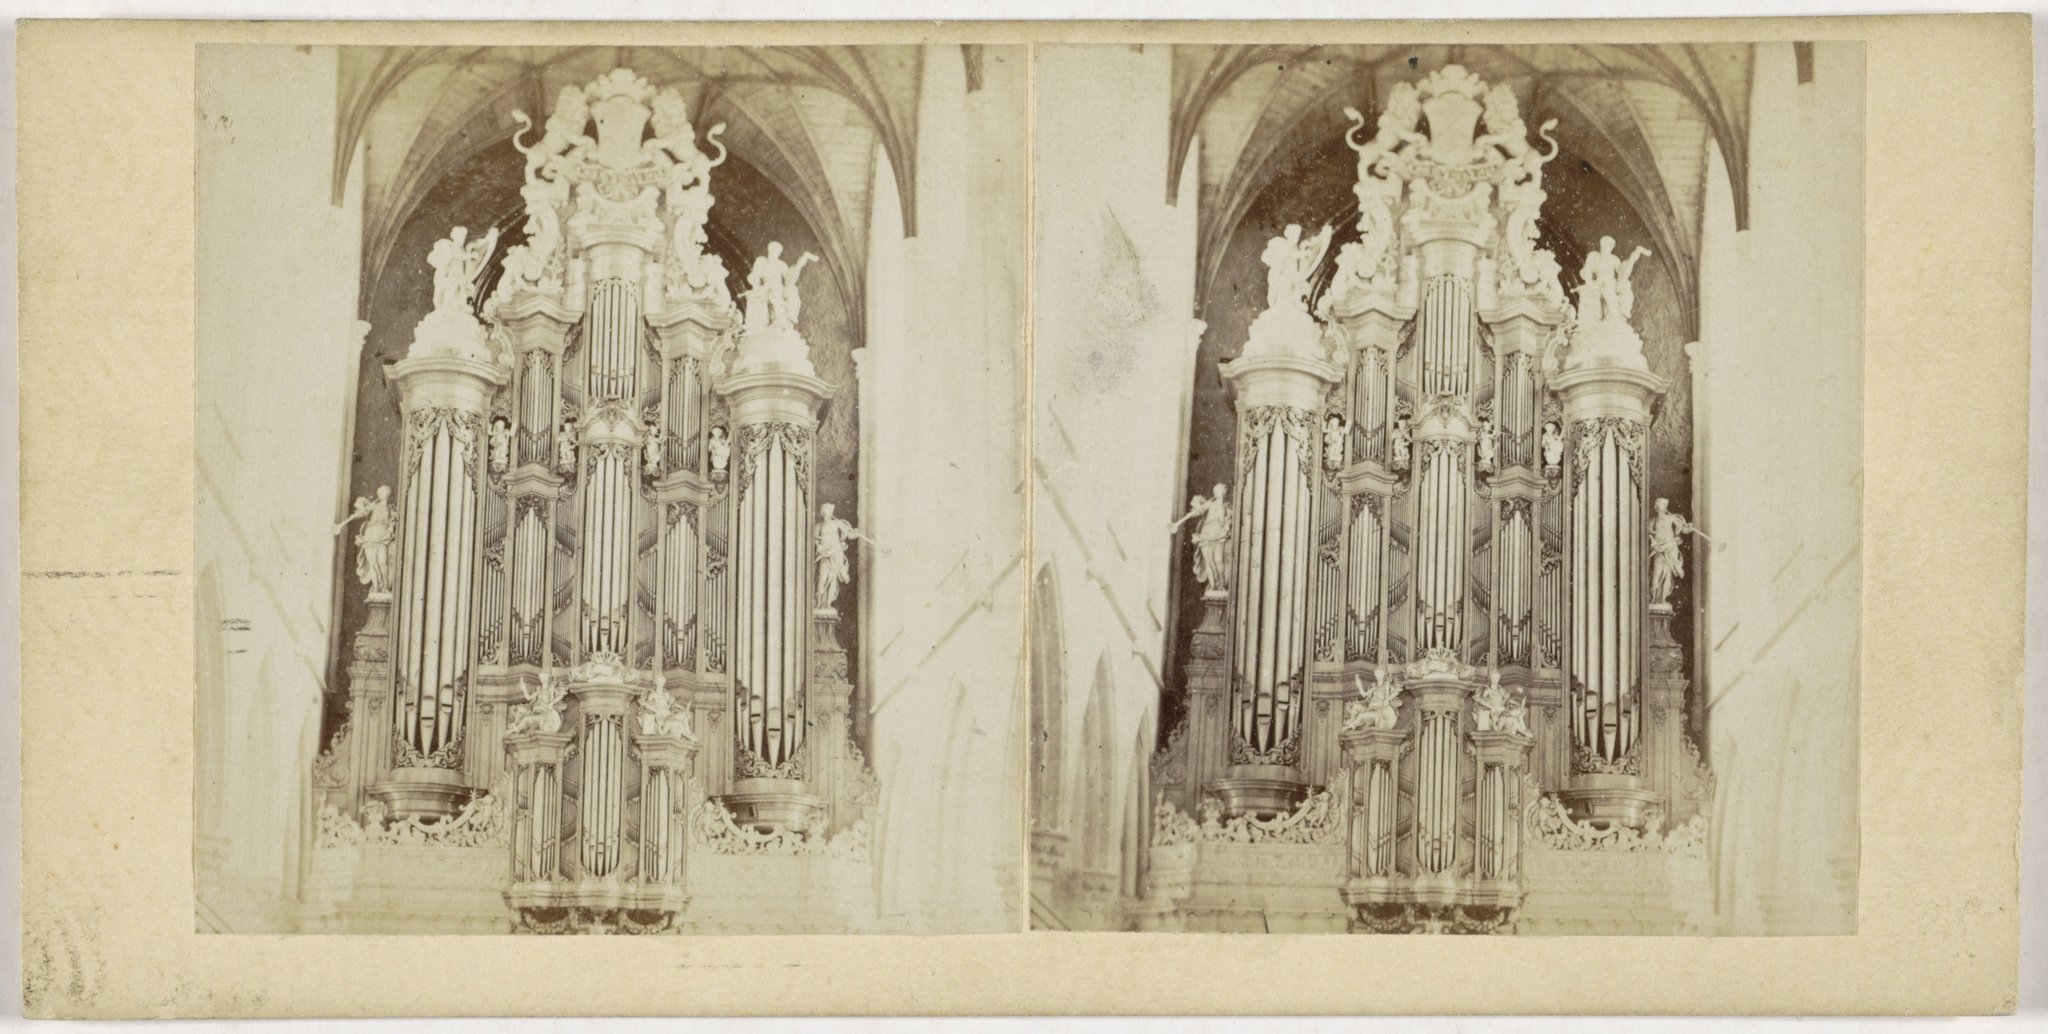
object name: stereograph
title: Orgel Groote Kerk, Haarlem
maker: Anonymous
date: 1857-1863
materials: cardboard, paper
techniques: albumen print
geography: haarlem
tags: church organ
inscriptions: inscription: ‘RBK’